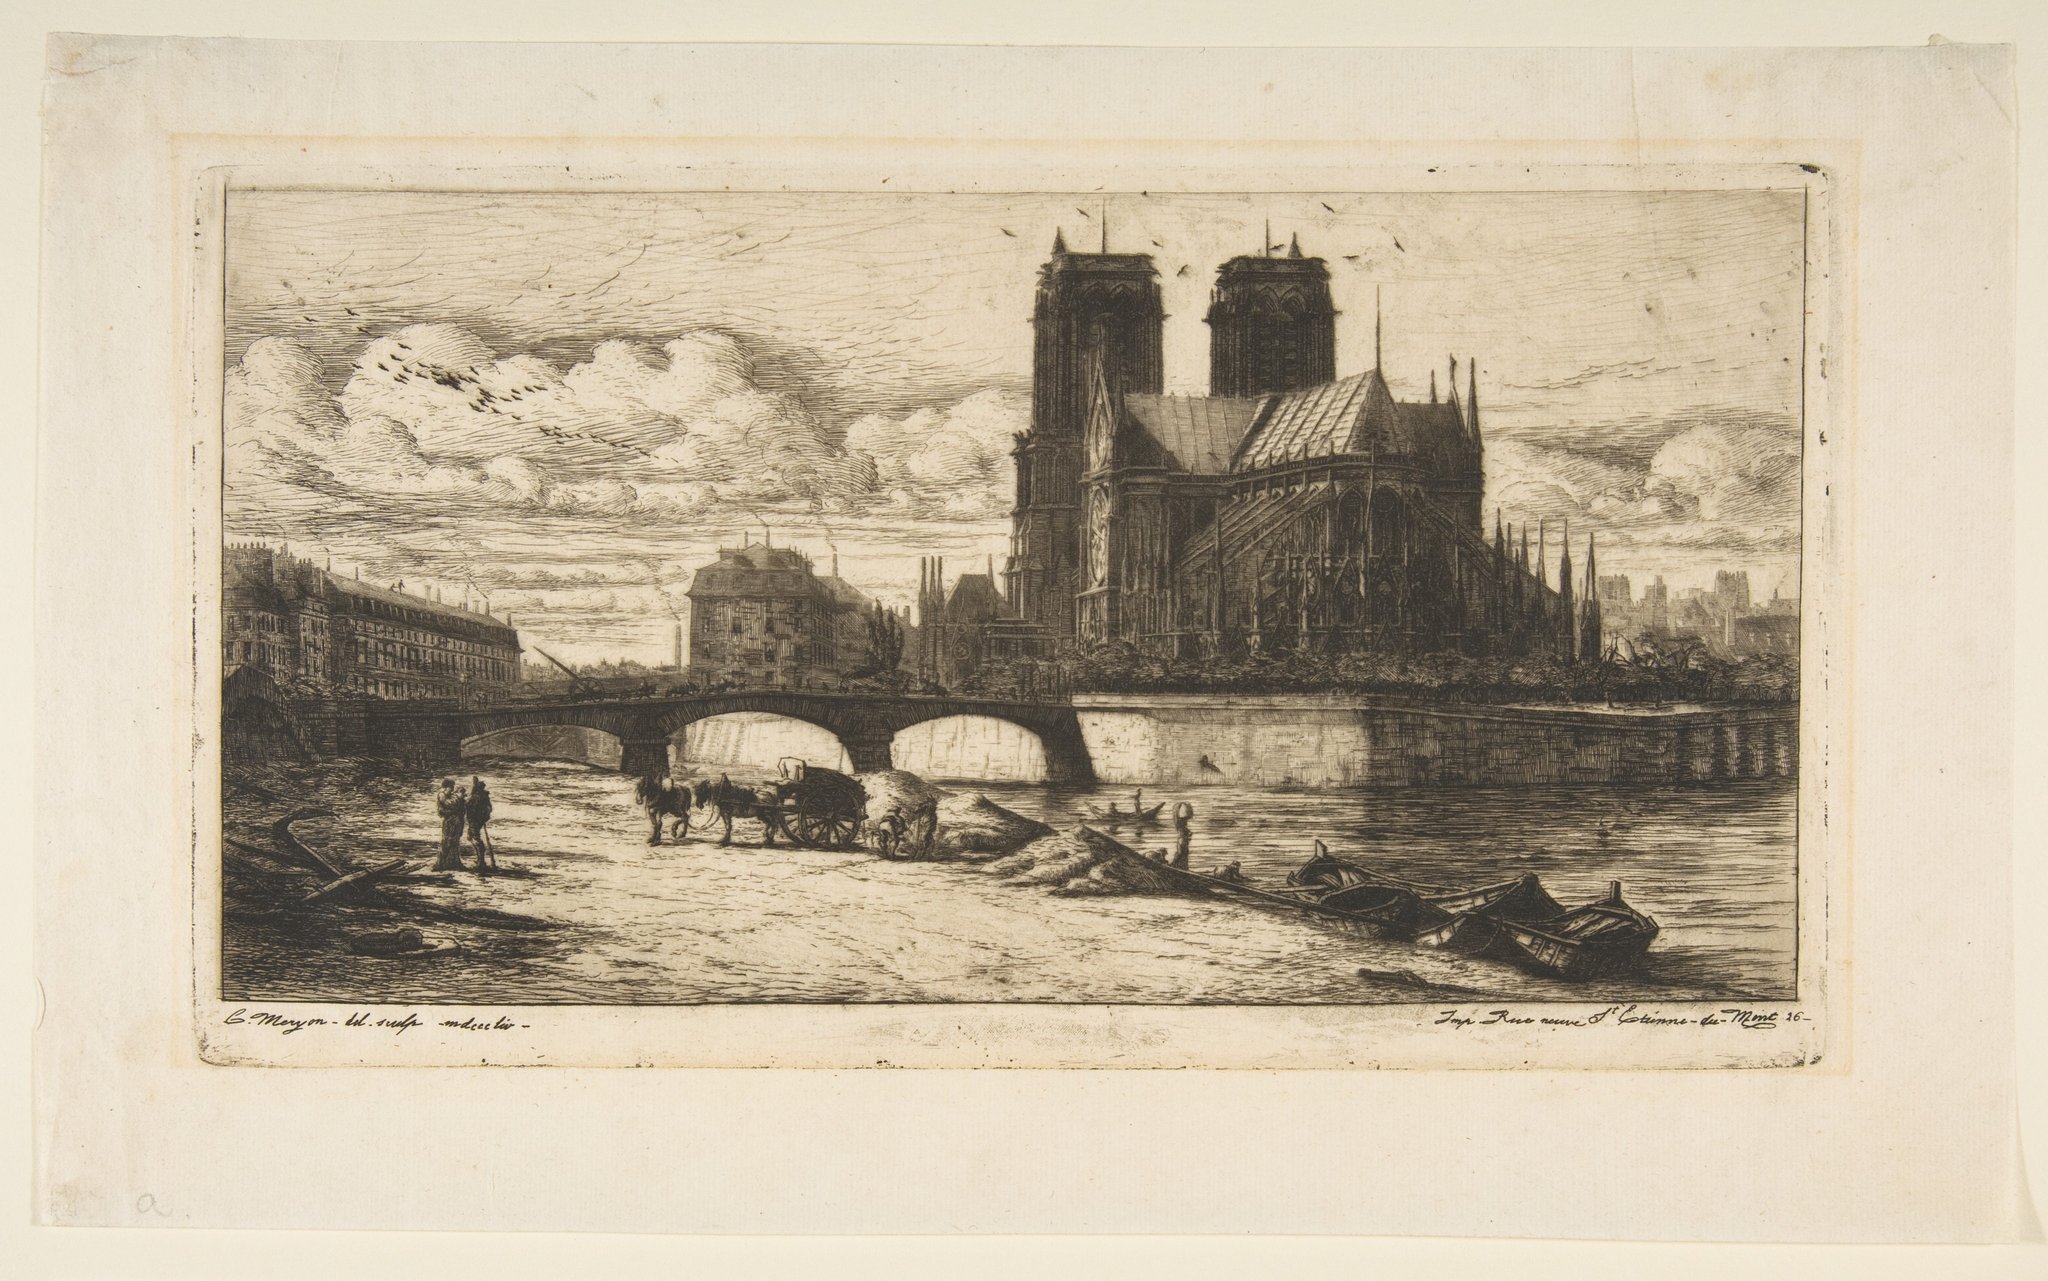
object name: print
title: The Apse of Notre-Dame, Paris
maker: charles meryon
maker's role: artist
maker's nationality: french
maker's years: 1821-1868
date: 1854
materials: paper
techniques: drypoint, engraving, etching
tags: bridges,cathedrals,boats,paris